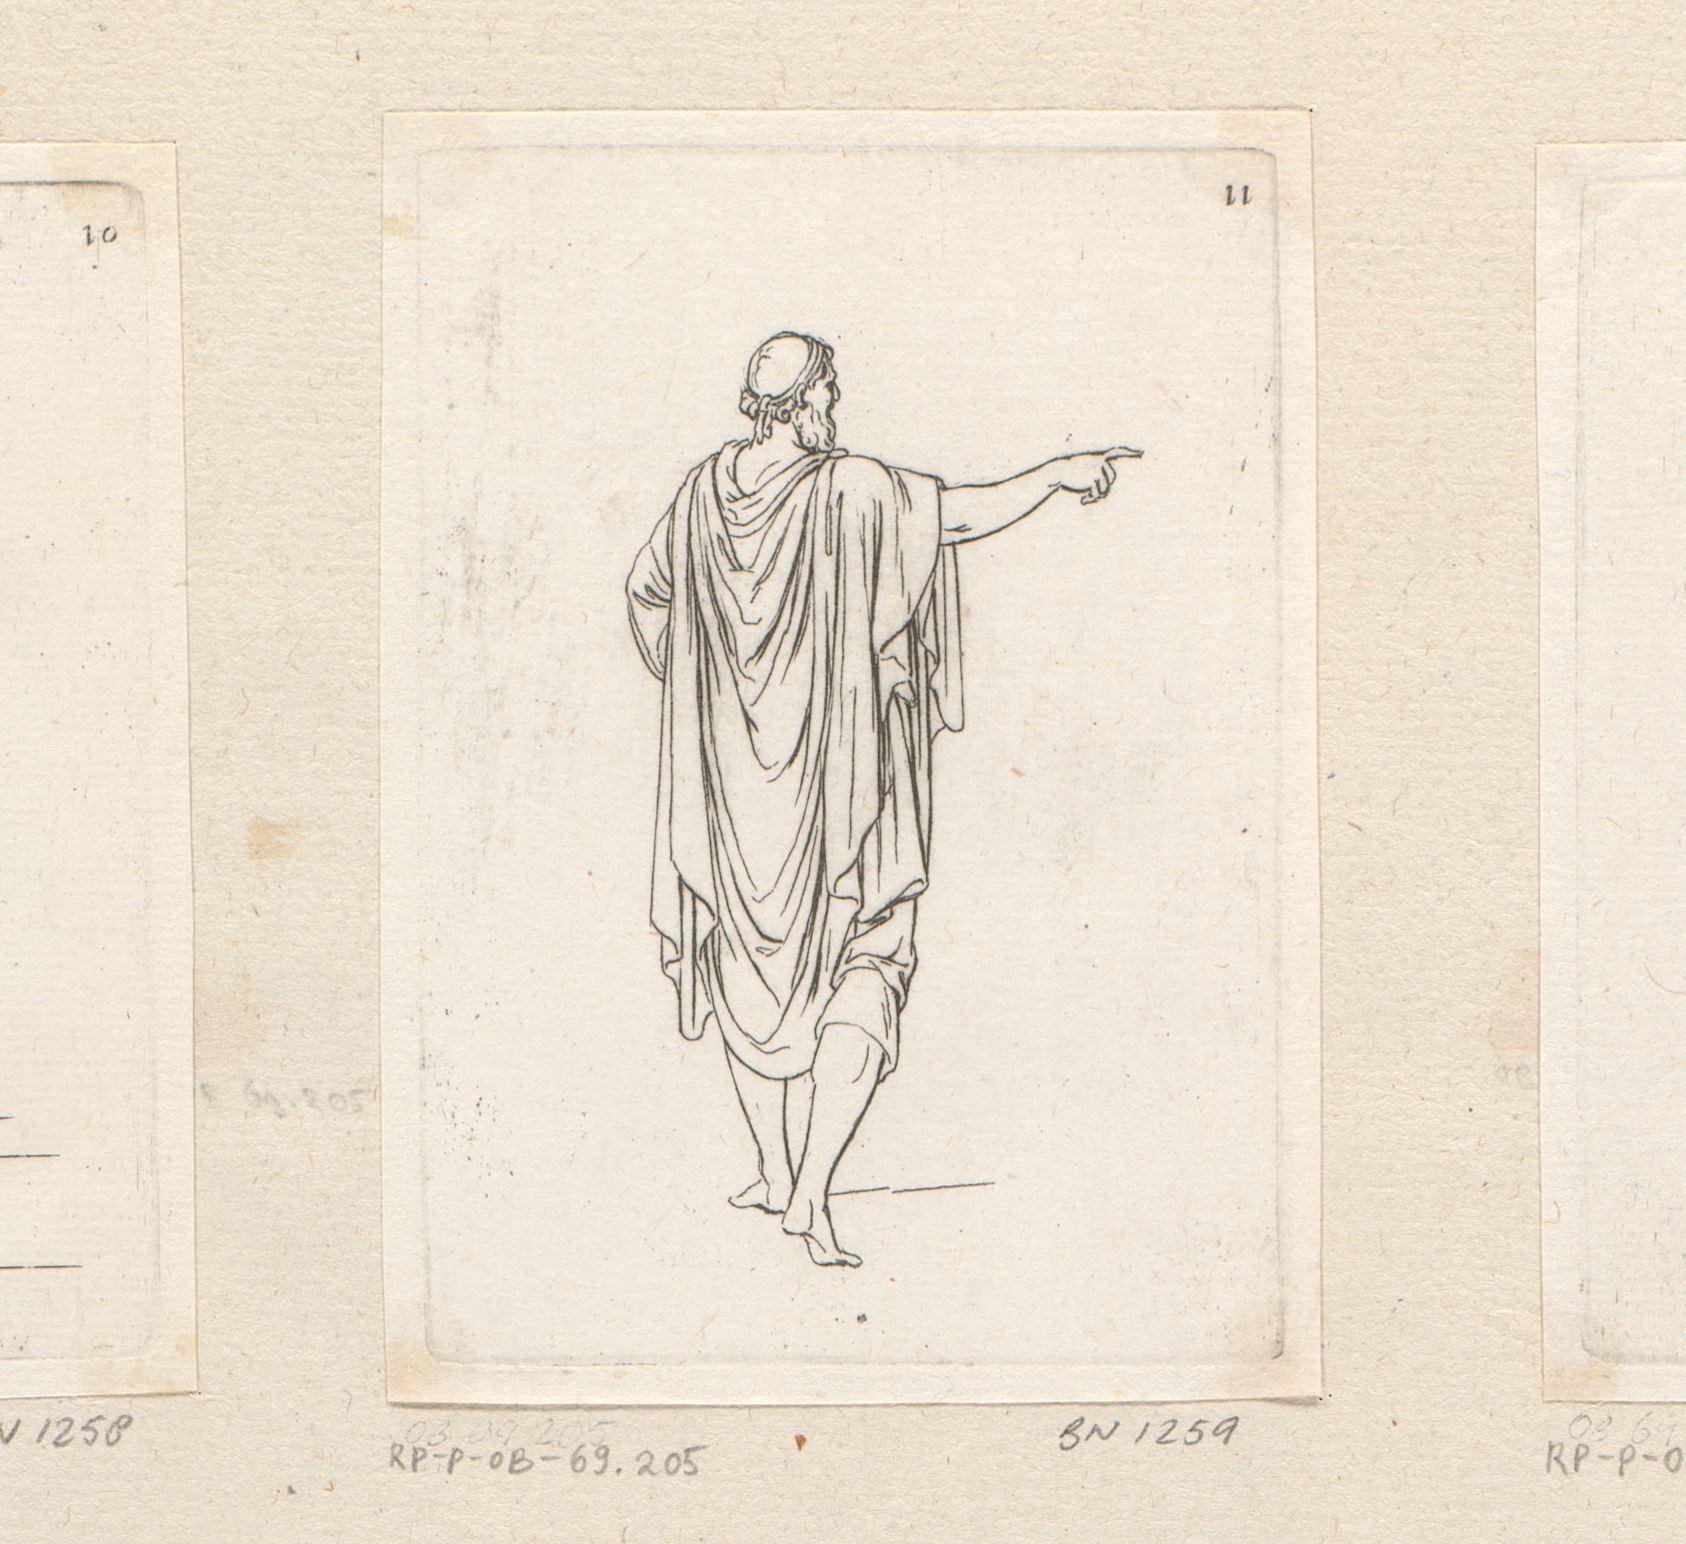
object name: print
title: Staande man naar rechts wijzend op de rug gezien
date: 1706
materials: paper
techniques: etching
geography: france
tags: adult man